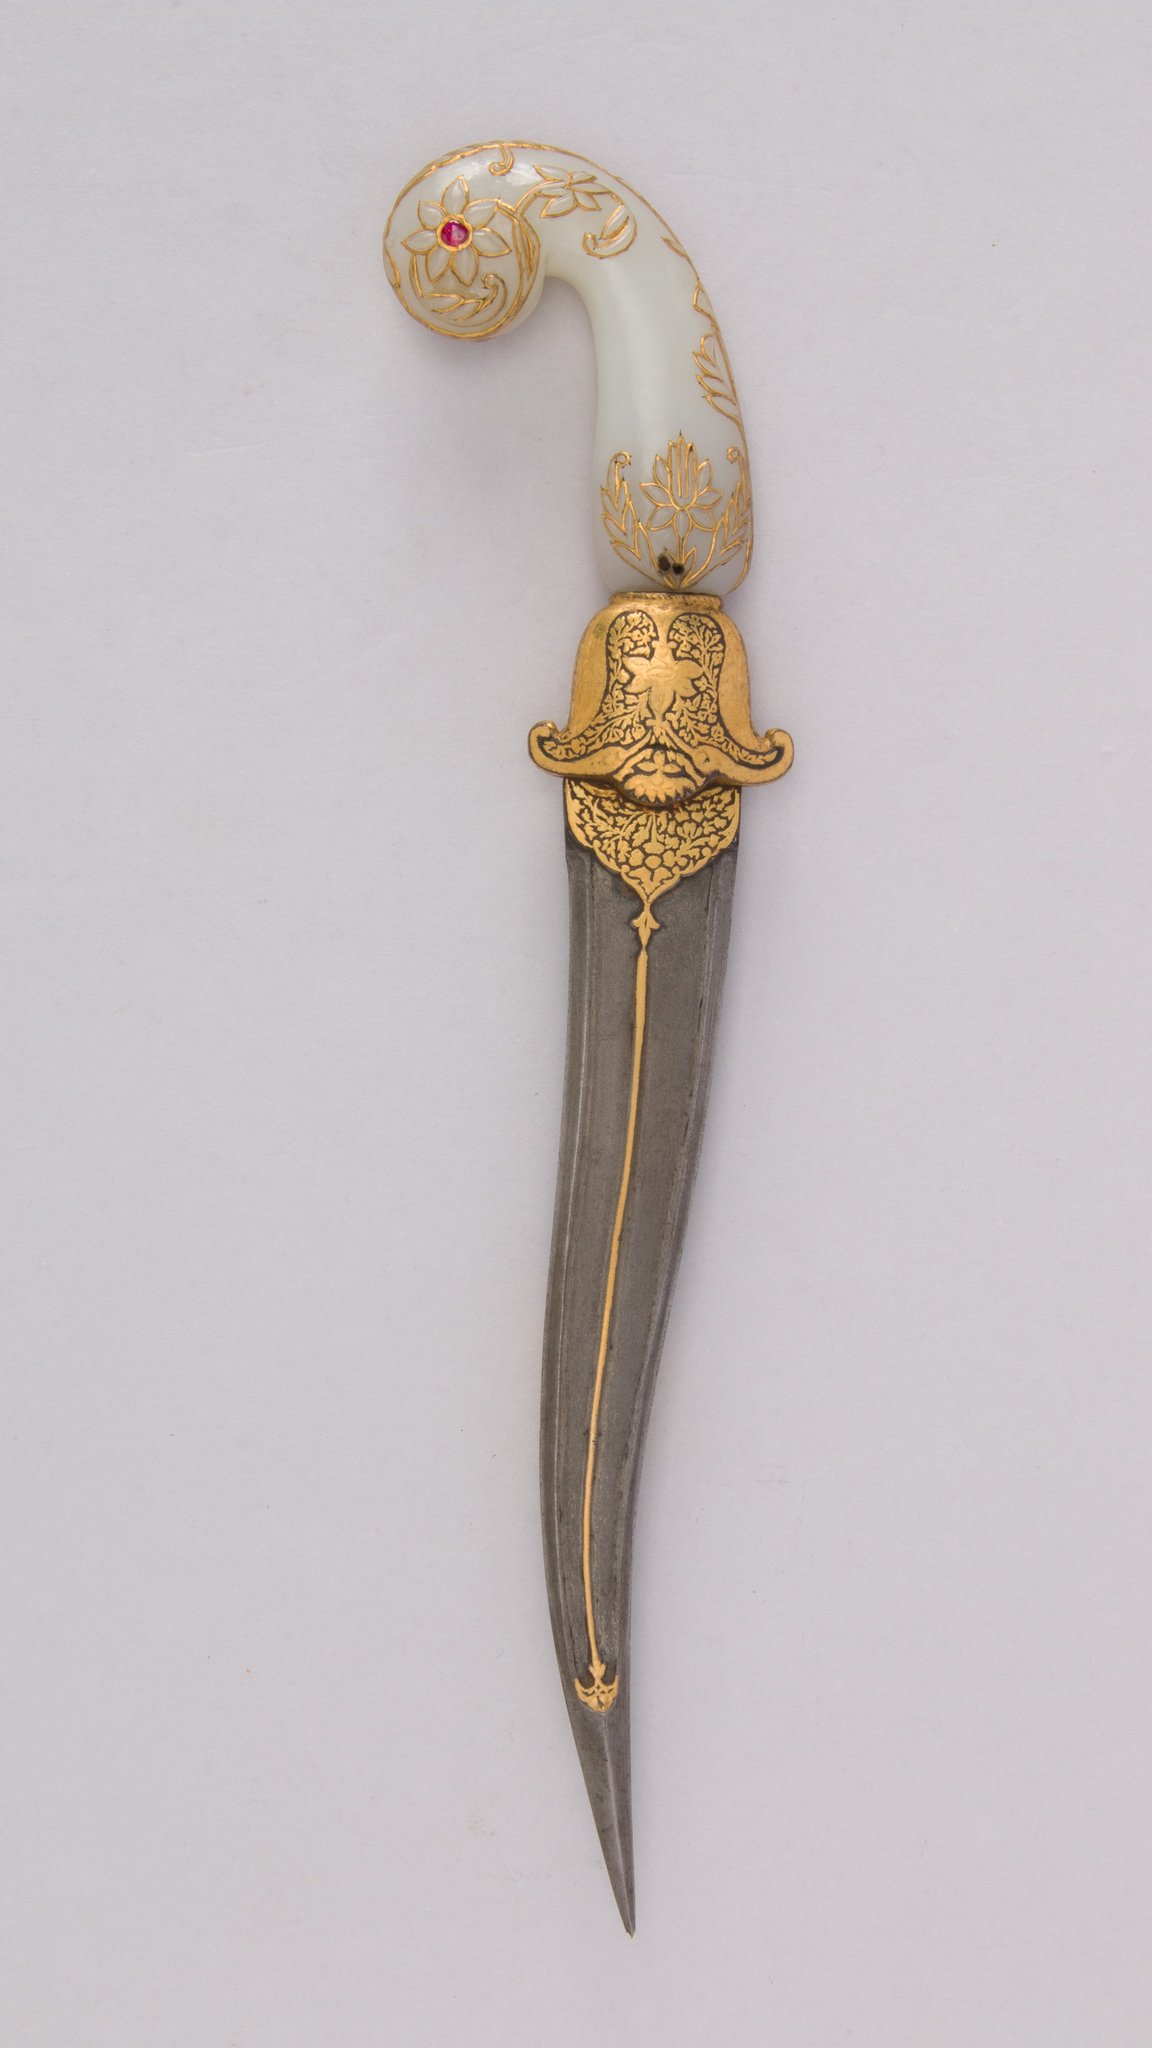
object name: dagger khanjar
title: Dagger (Khanjar)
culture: indian, deccan or mughal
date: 1701-1900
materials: gold, jade, gemstone, steel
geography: india